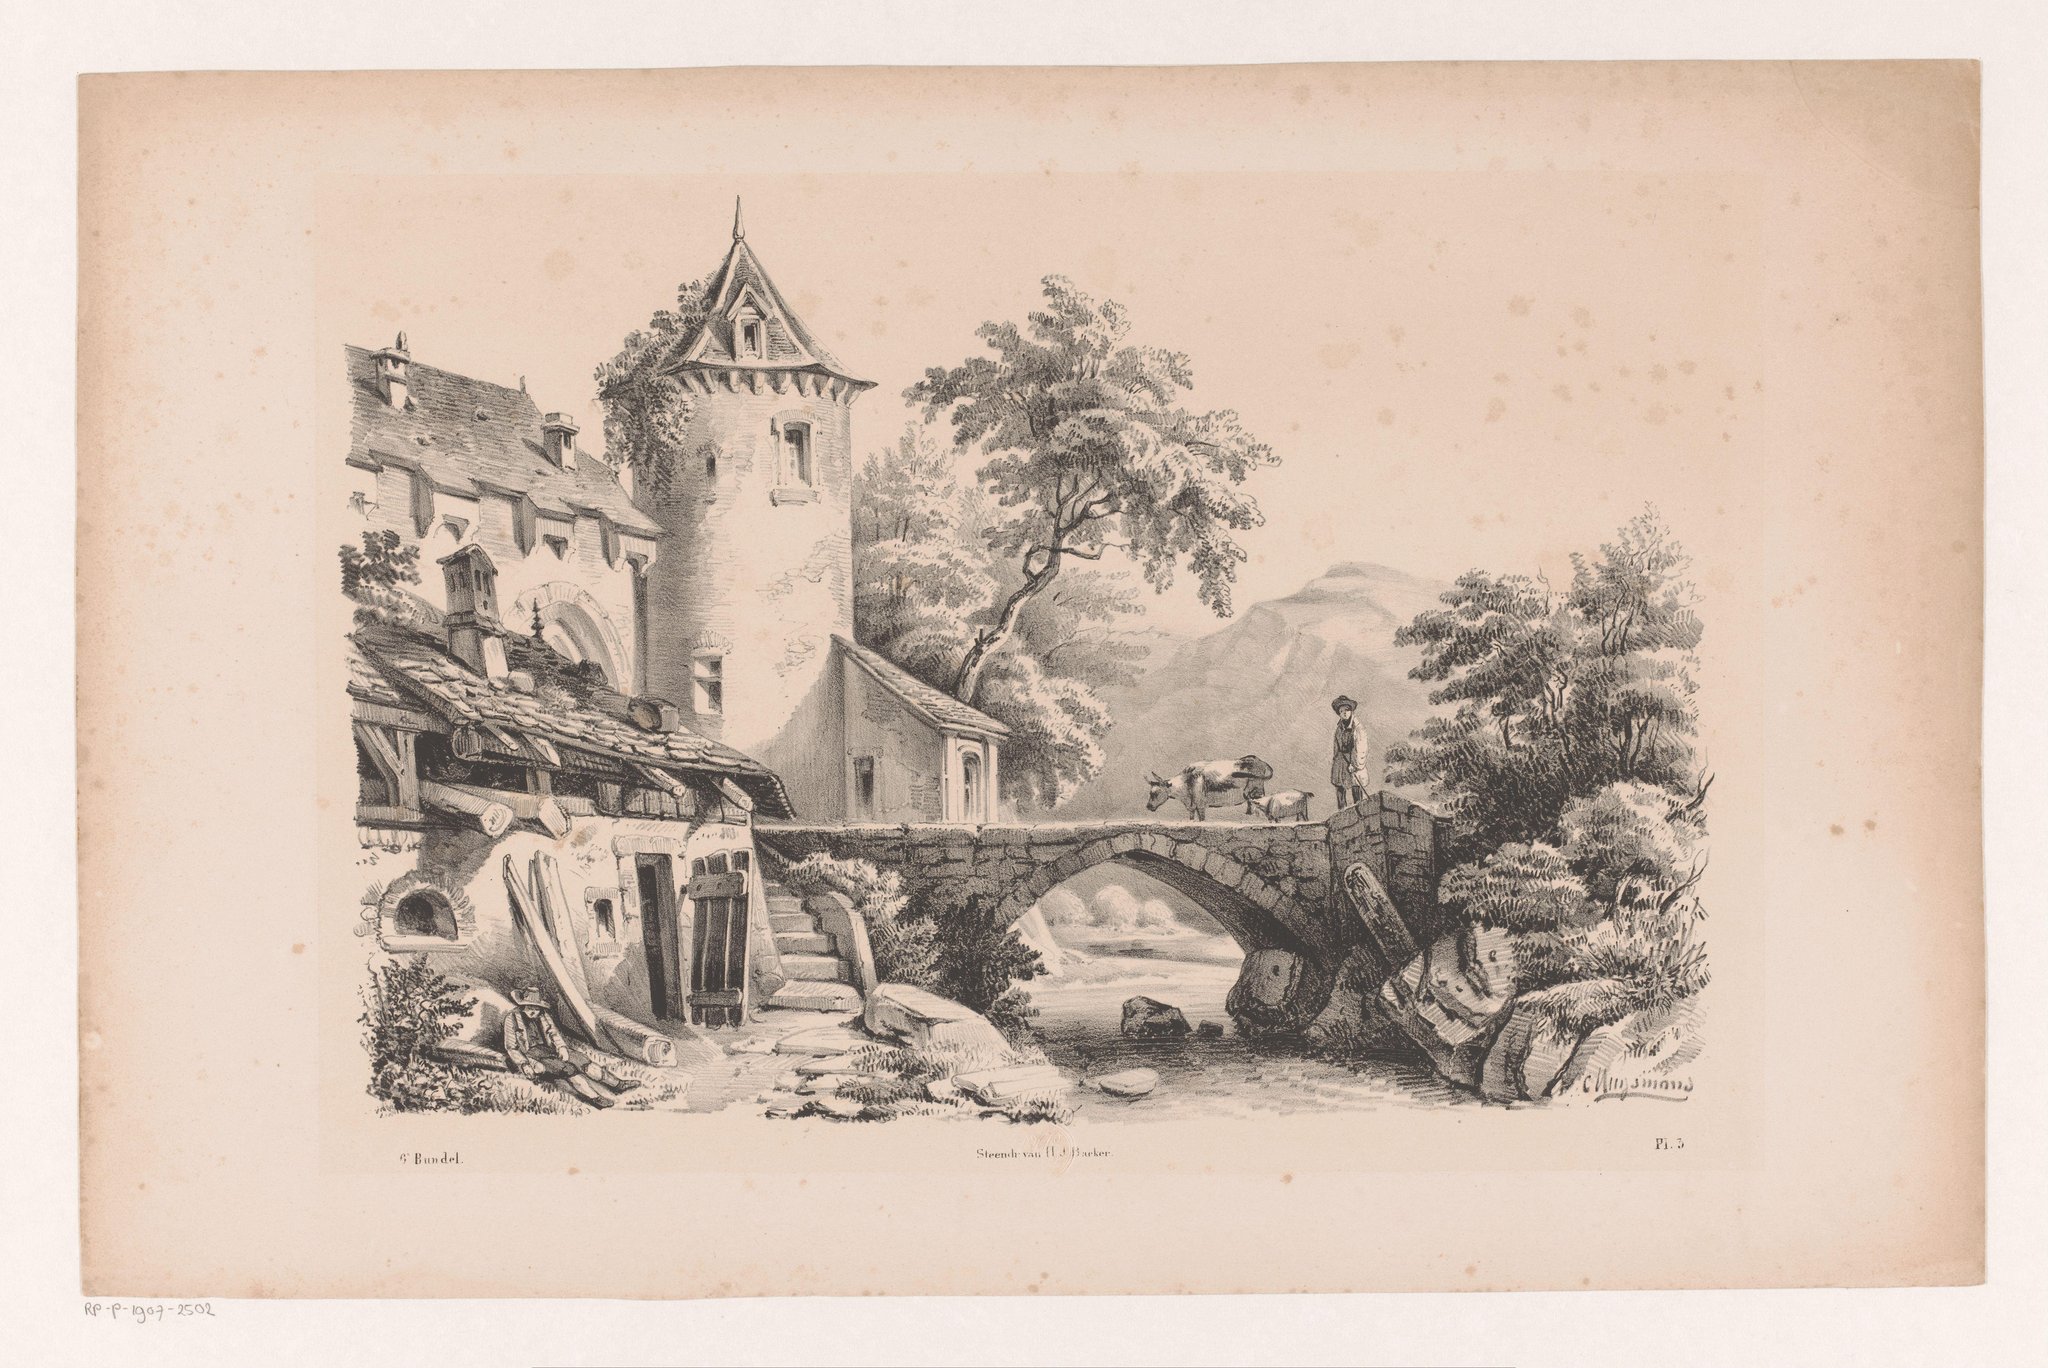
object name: print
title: Huizen en brug in berglandschap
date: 1838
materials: paper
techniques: lithograph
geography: dordrecht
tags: cow, bridge, goat, landscapes in the temperate zone (+ landscape with figures, staffage)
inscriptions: collector's mark: Lugt 2228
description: Deze prent maakt deel uit van een serie getiteld 'Het Landschap' door Constantinus Cornelis Huysmans. Deze serie werd door hem gebruikt als lesmateriaal op de Koninklijke Militaire Academie te Breda. Hij was docent handtekenen van 1837 tot 1866. Zie: W. van Giersbergen.